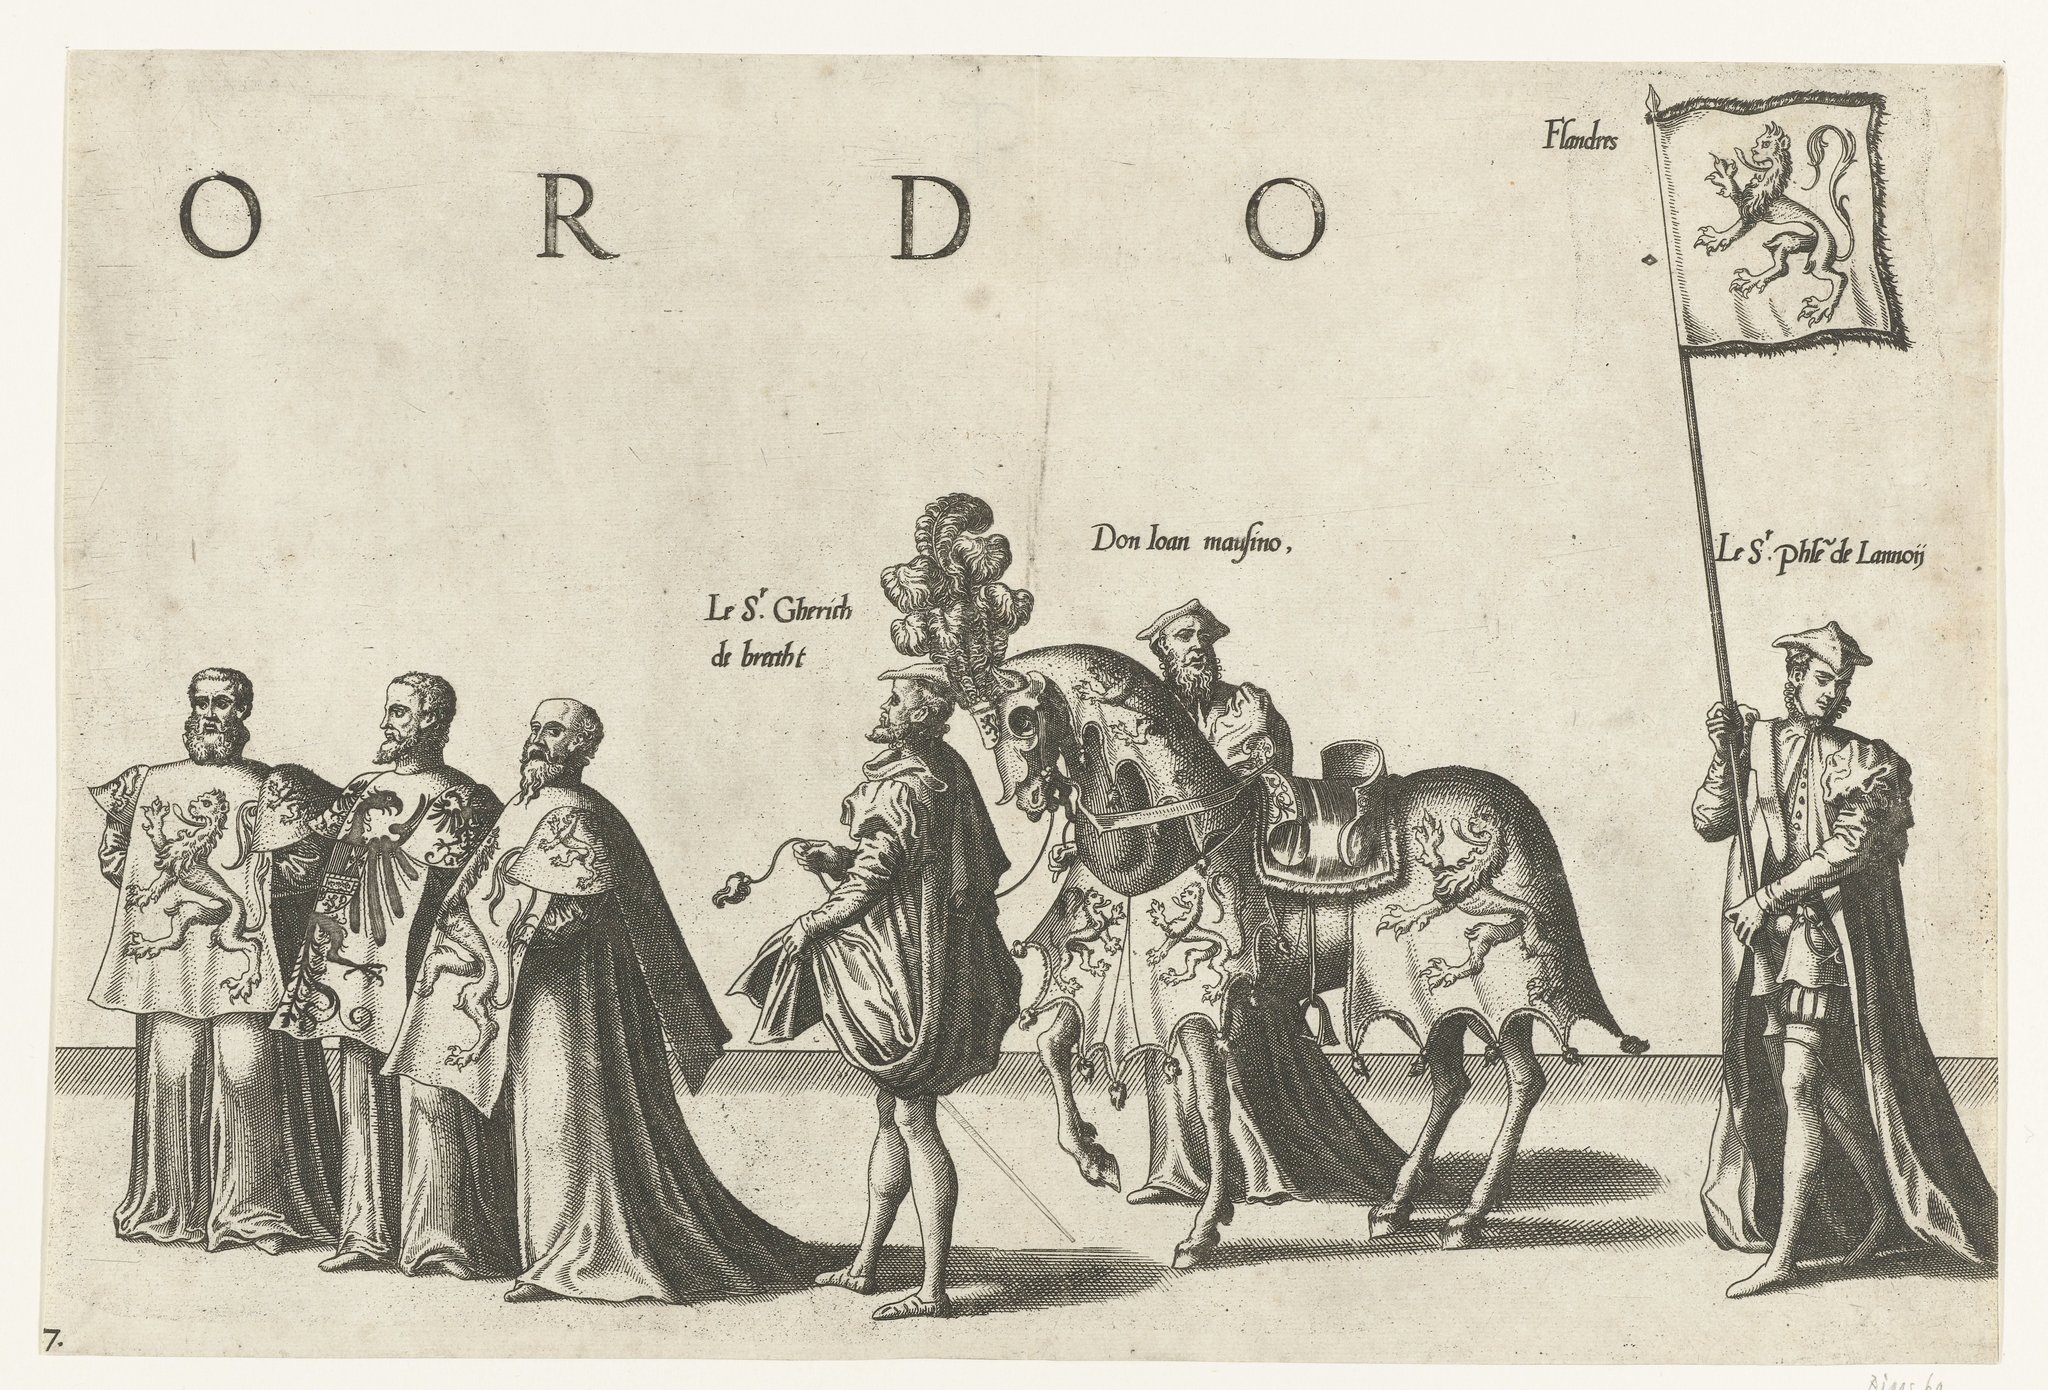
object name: print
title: Begrafenisoptocht van keizer Karel V, 1558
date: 1559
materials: paper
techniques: engraving, etching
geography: southern netherlands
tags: ghent, charles v (holy roman emperor and king of spain), cortege, funeral procession, brussels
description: Zes deelnemers aan de optocht, paard en het vaandel met het wapen van Vlaanderen. Onderdeel van de prentreeks van de Begrafenisoptocht van keizer Karel V op 29 december 1558 te Brussel.